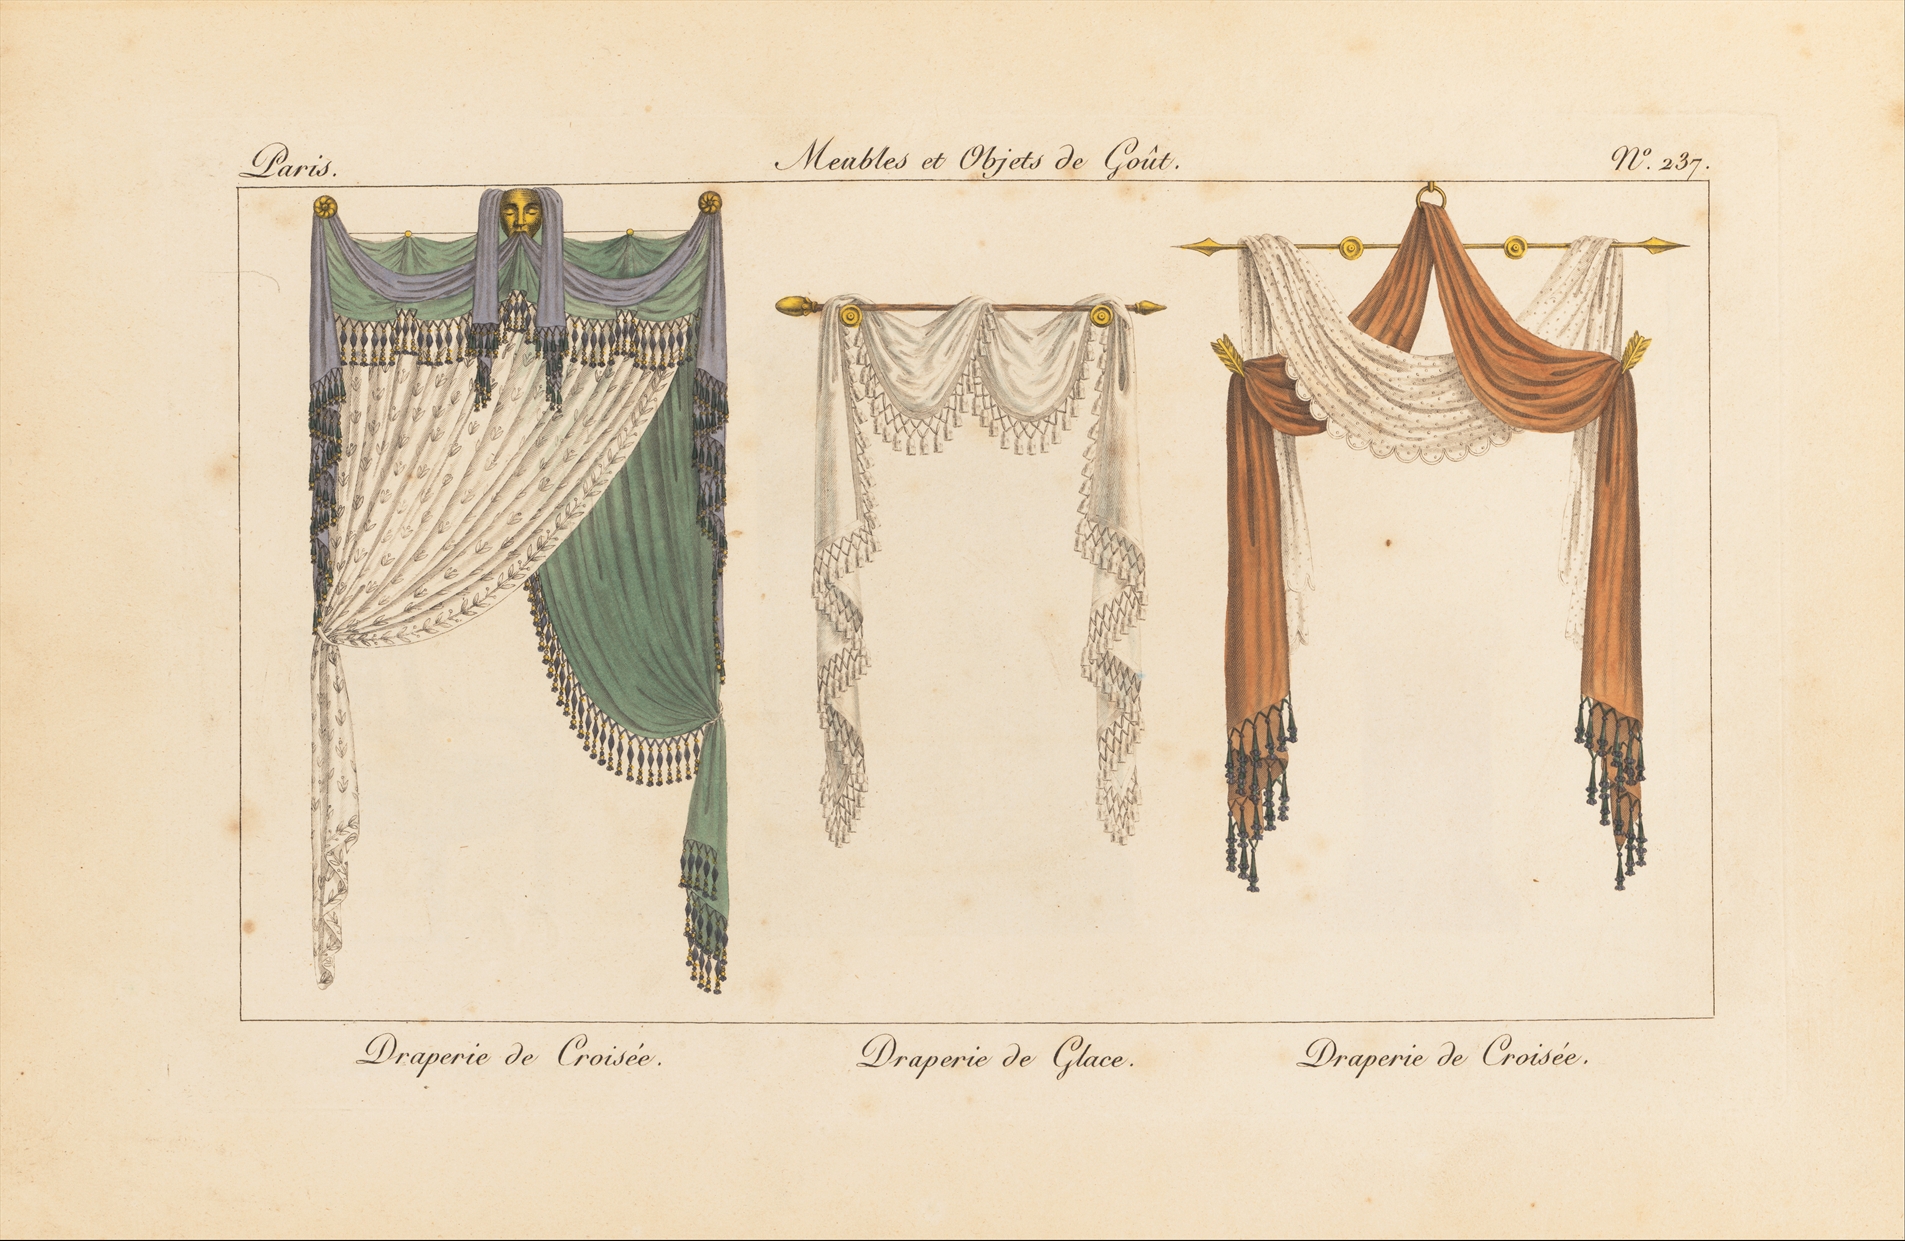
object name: book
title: Collection de Meubles et Objets de Goût, vol. 1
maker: pierre de la mésangère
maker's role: editor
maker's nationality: french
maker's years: 1761-1831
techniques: engraving, hand coloring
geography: france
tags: curtains